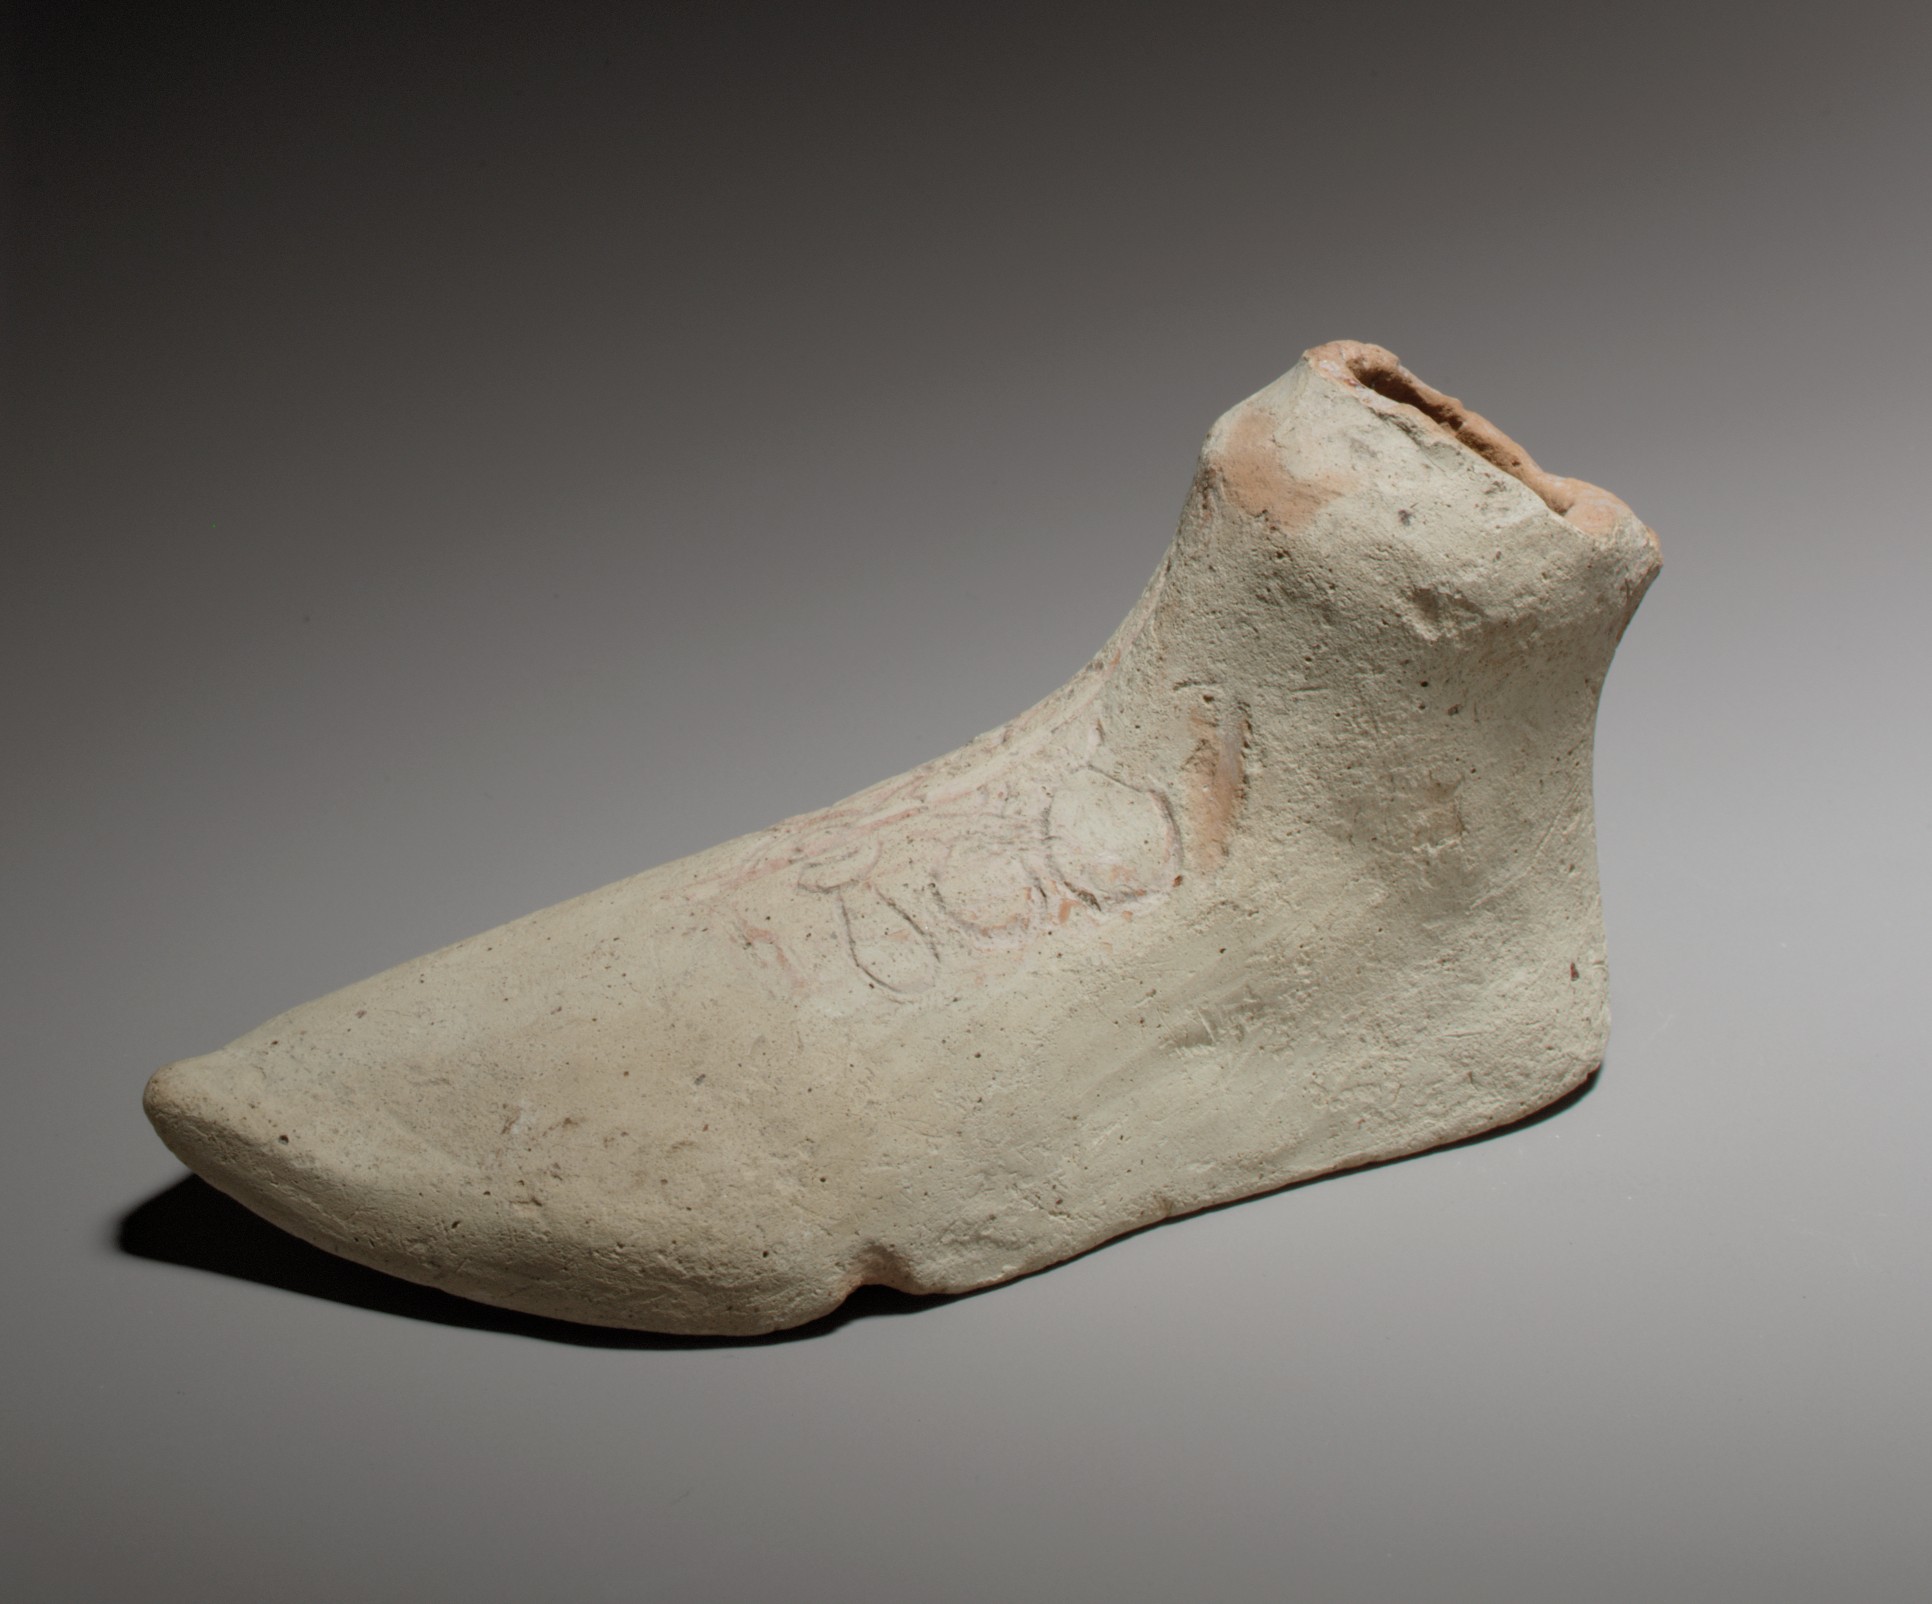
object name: foot with shoe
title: Left foot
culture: east greek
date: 600-480 BCE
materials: terracotta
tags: feet